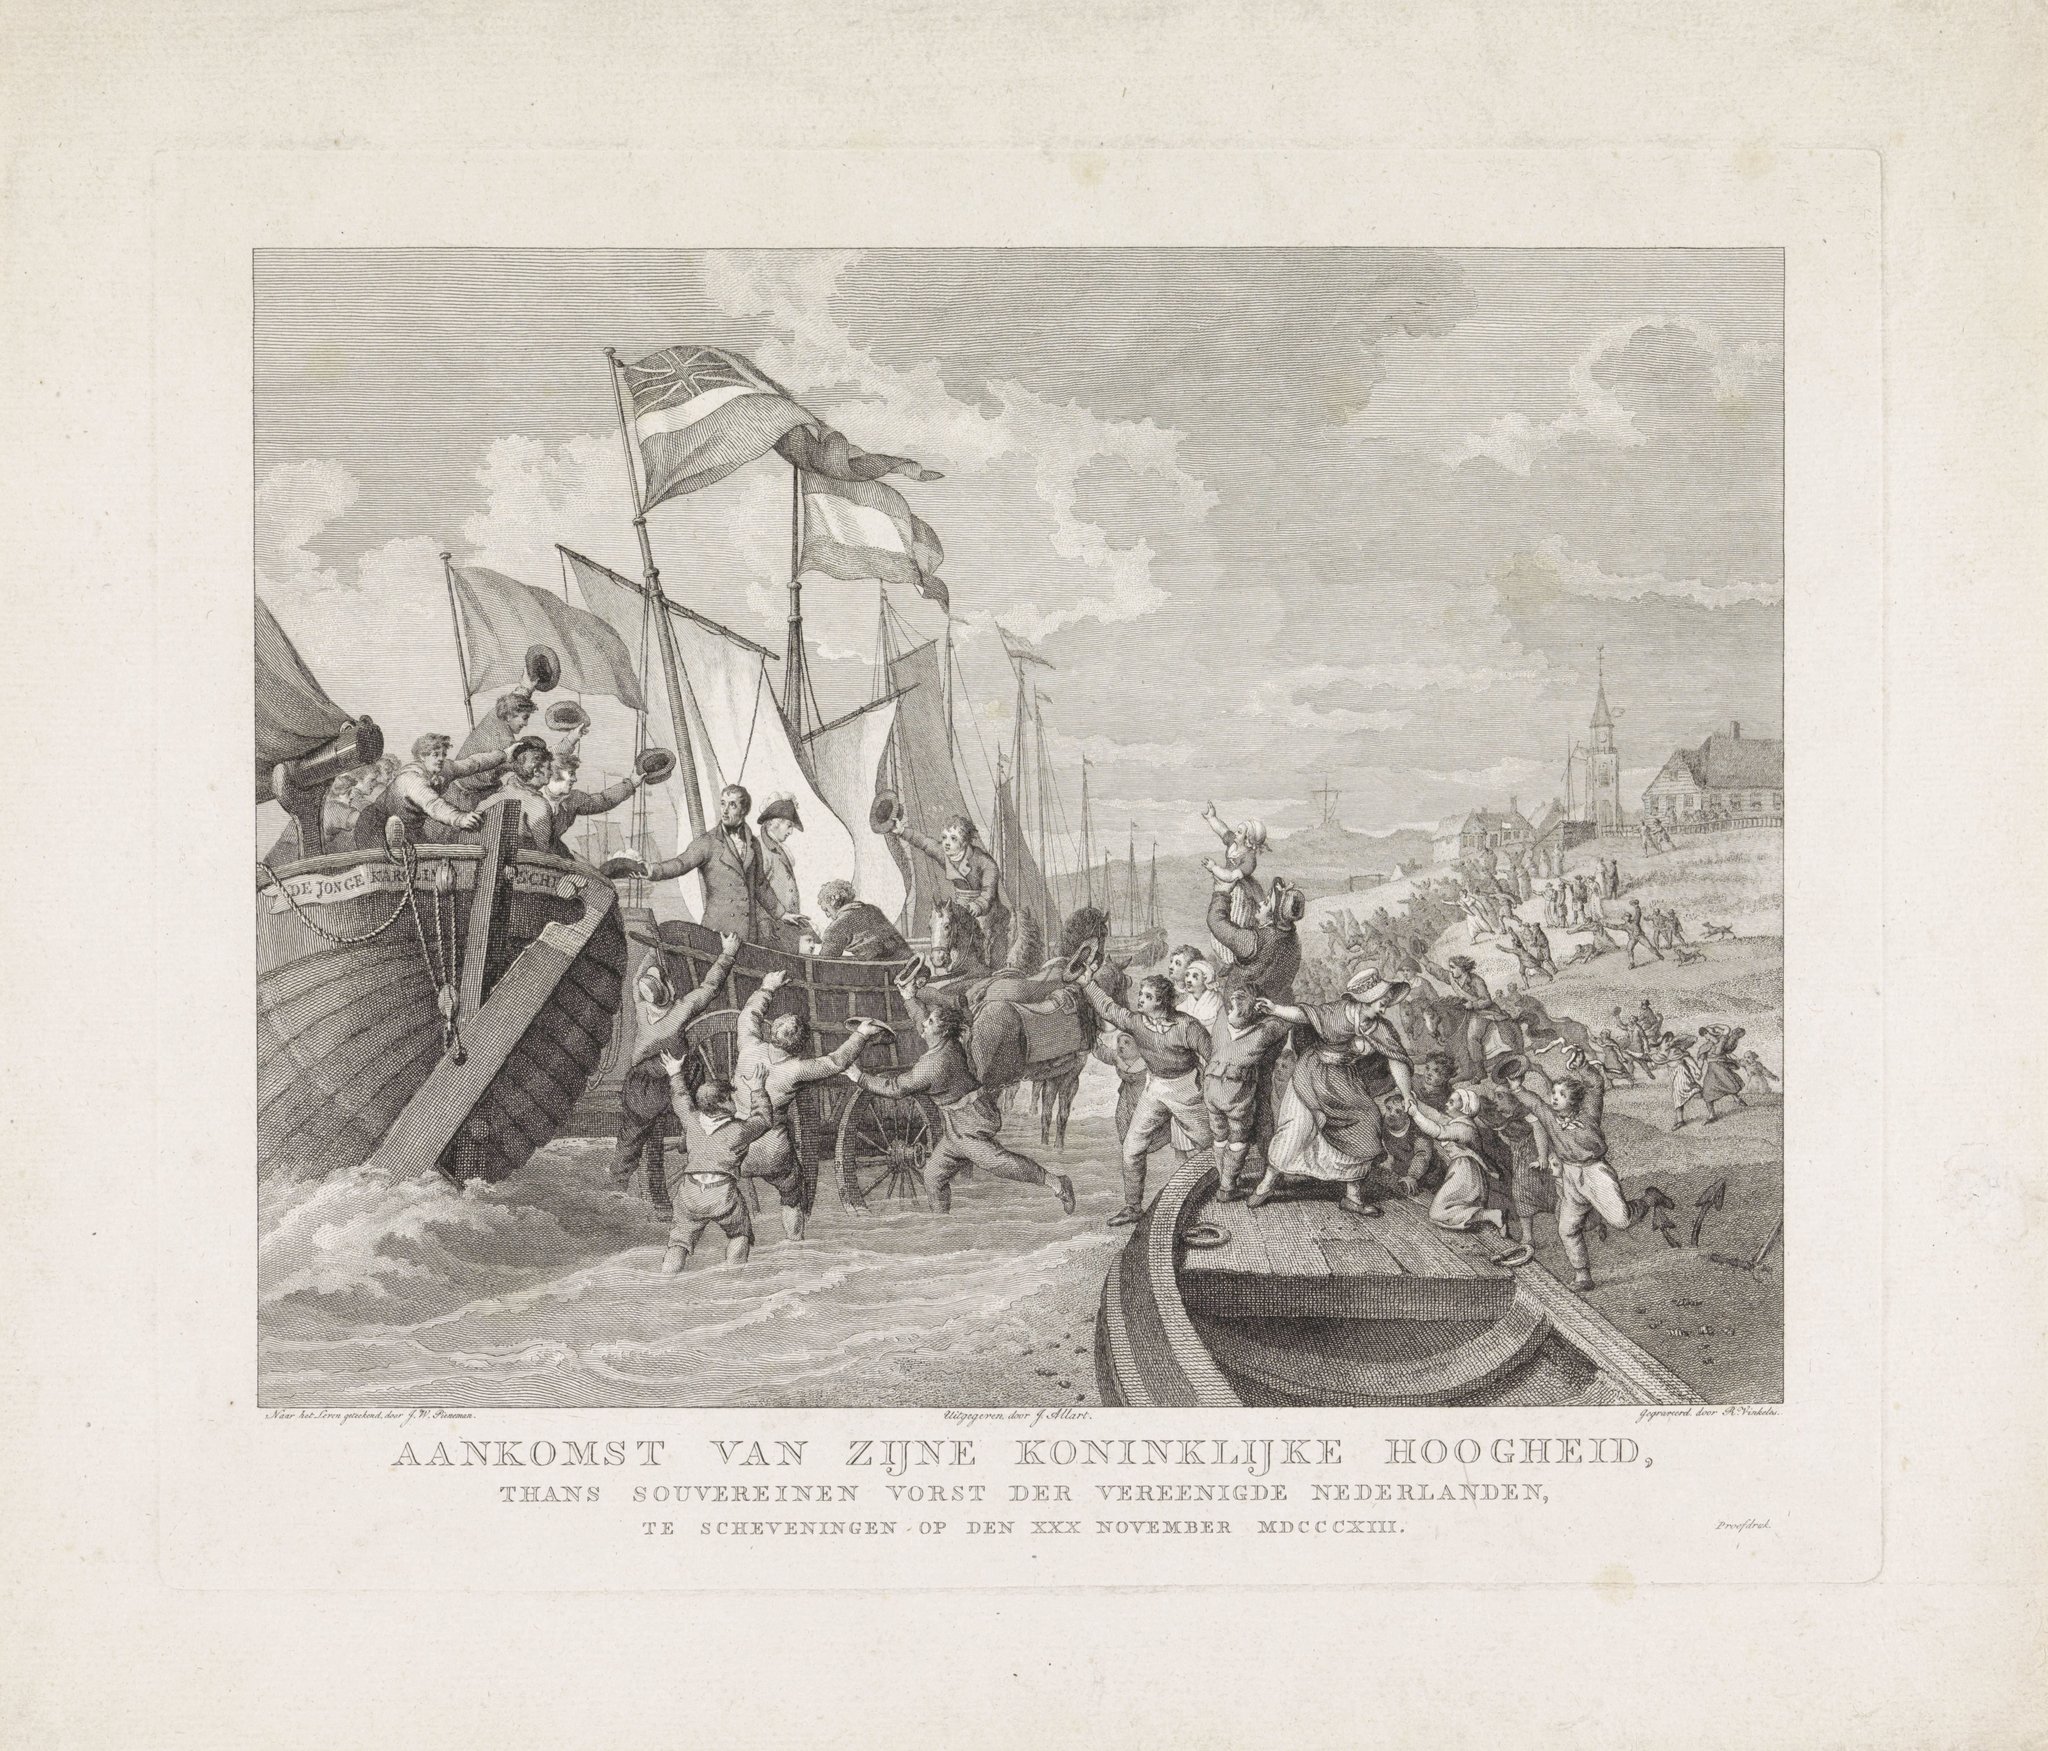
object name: print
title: Aankomst van koning Willem I te Scheveningen, 1813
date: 1813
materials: paper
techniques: engraving, etching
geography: netherlands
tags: the hague, berlin, william i of the netherlands, being welcomed ~ travelling, homage to a ruler, landing of william frederick i (1813)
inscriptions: collector's mark: Lugt 2228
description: Aankomst van prins Willem Frederik op het strand van Scheveningen, 30 november 1813, om als soeverein vorst de regering van het land op zich te nemen. De prins staande in de boerenwagen, links de visserspink 'De Jonge Karolina' die hem naar de kust heeft gebracht. Op het strand begroet een enthousiaste menigte de prins.